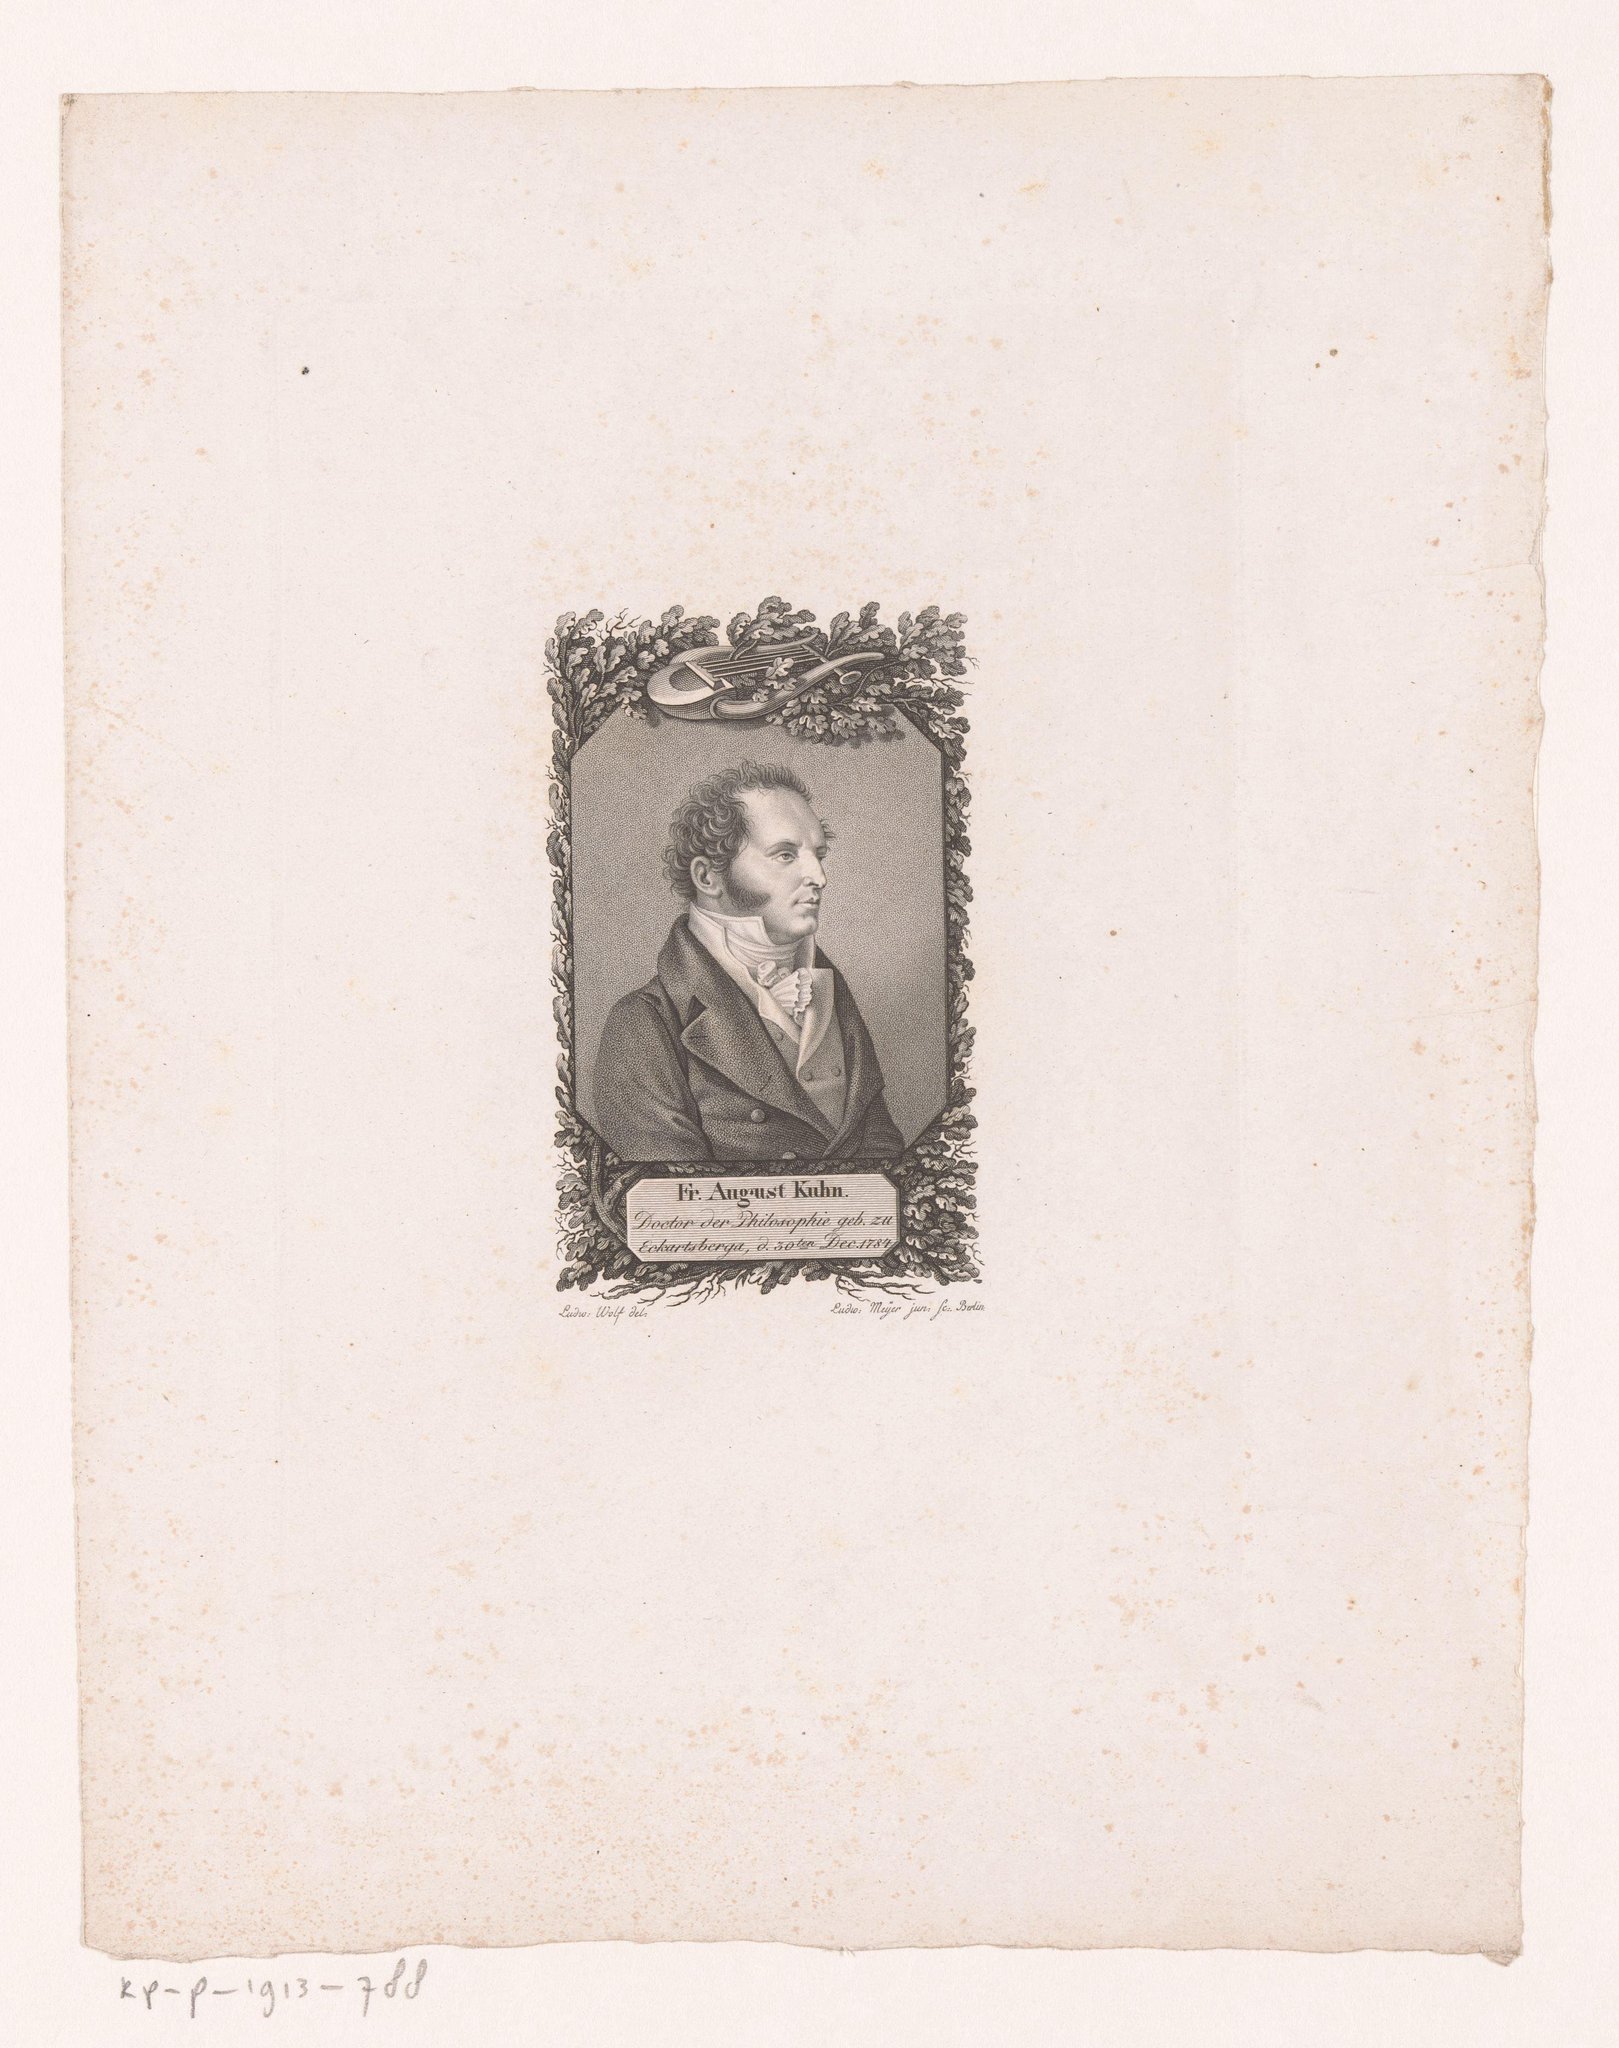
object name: print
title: Portret van Friedrich August Kuhn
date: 1754-1850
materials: paper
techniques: engraving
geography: berlin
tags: berlin, lyre, cithara, psaltery, portrait of a writer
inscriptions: collector's mark: Lugt 2228